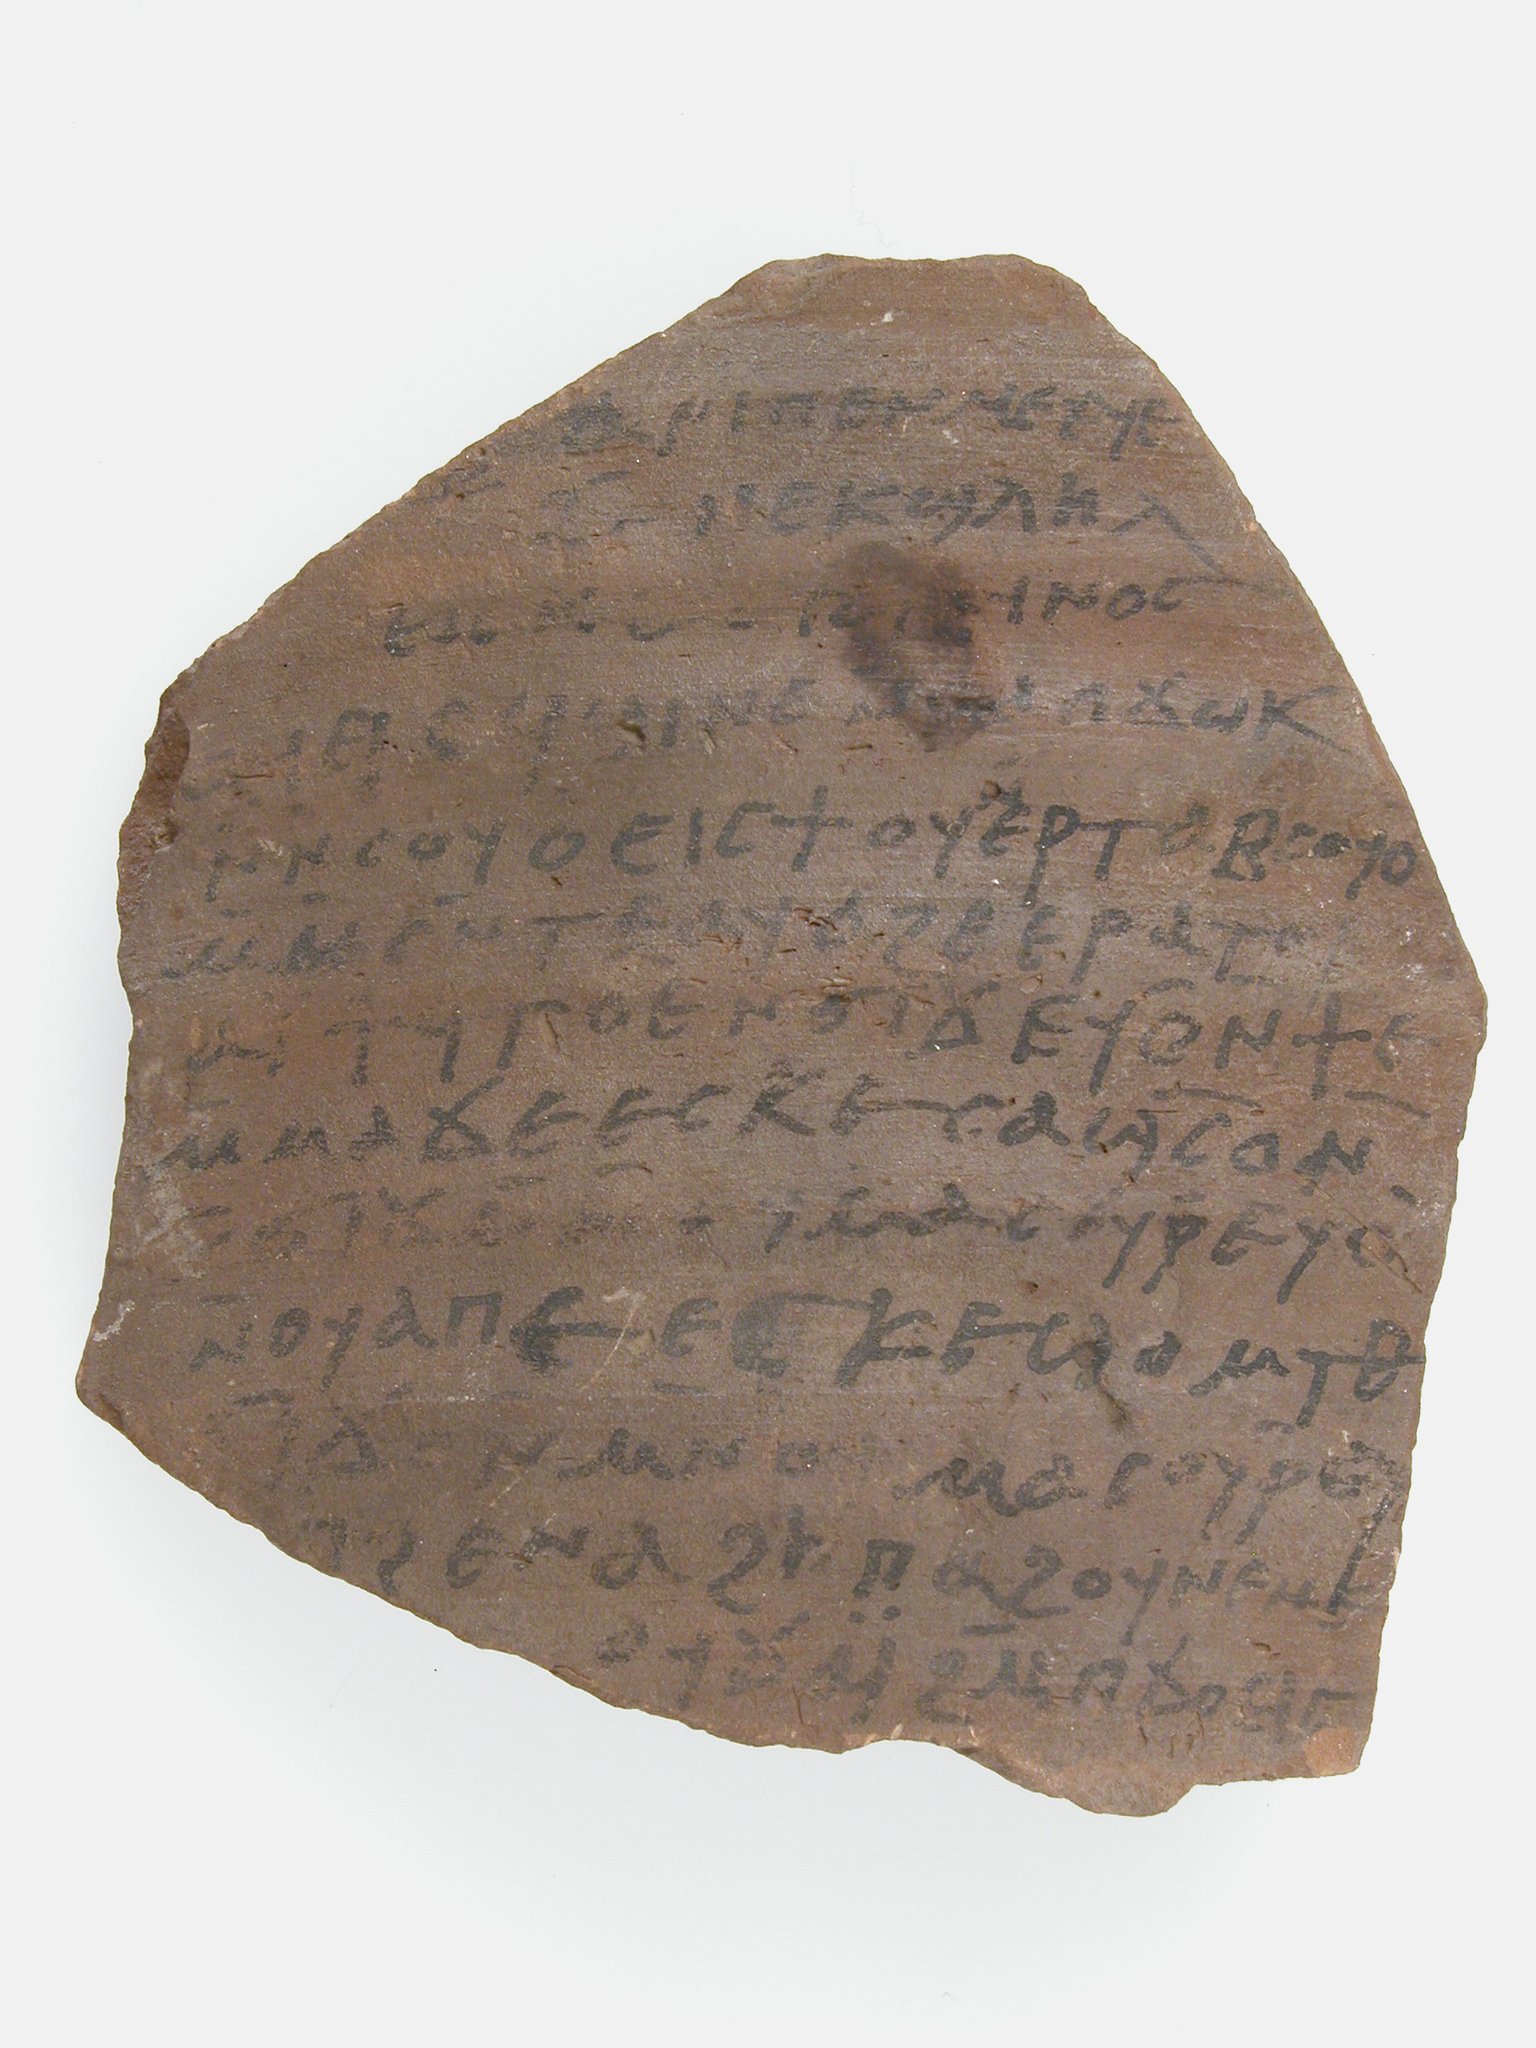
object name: ostrakon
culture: coptic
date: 601-700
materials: ink, pottery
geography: egypt